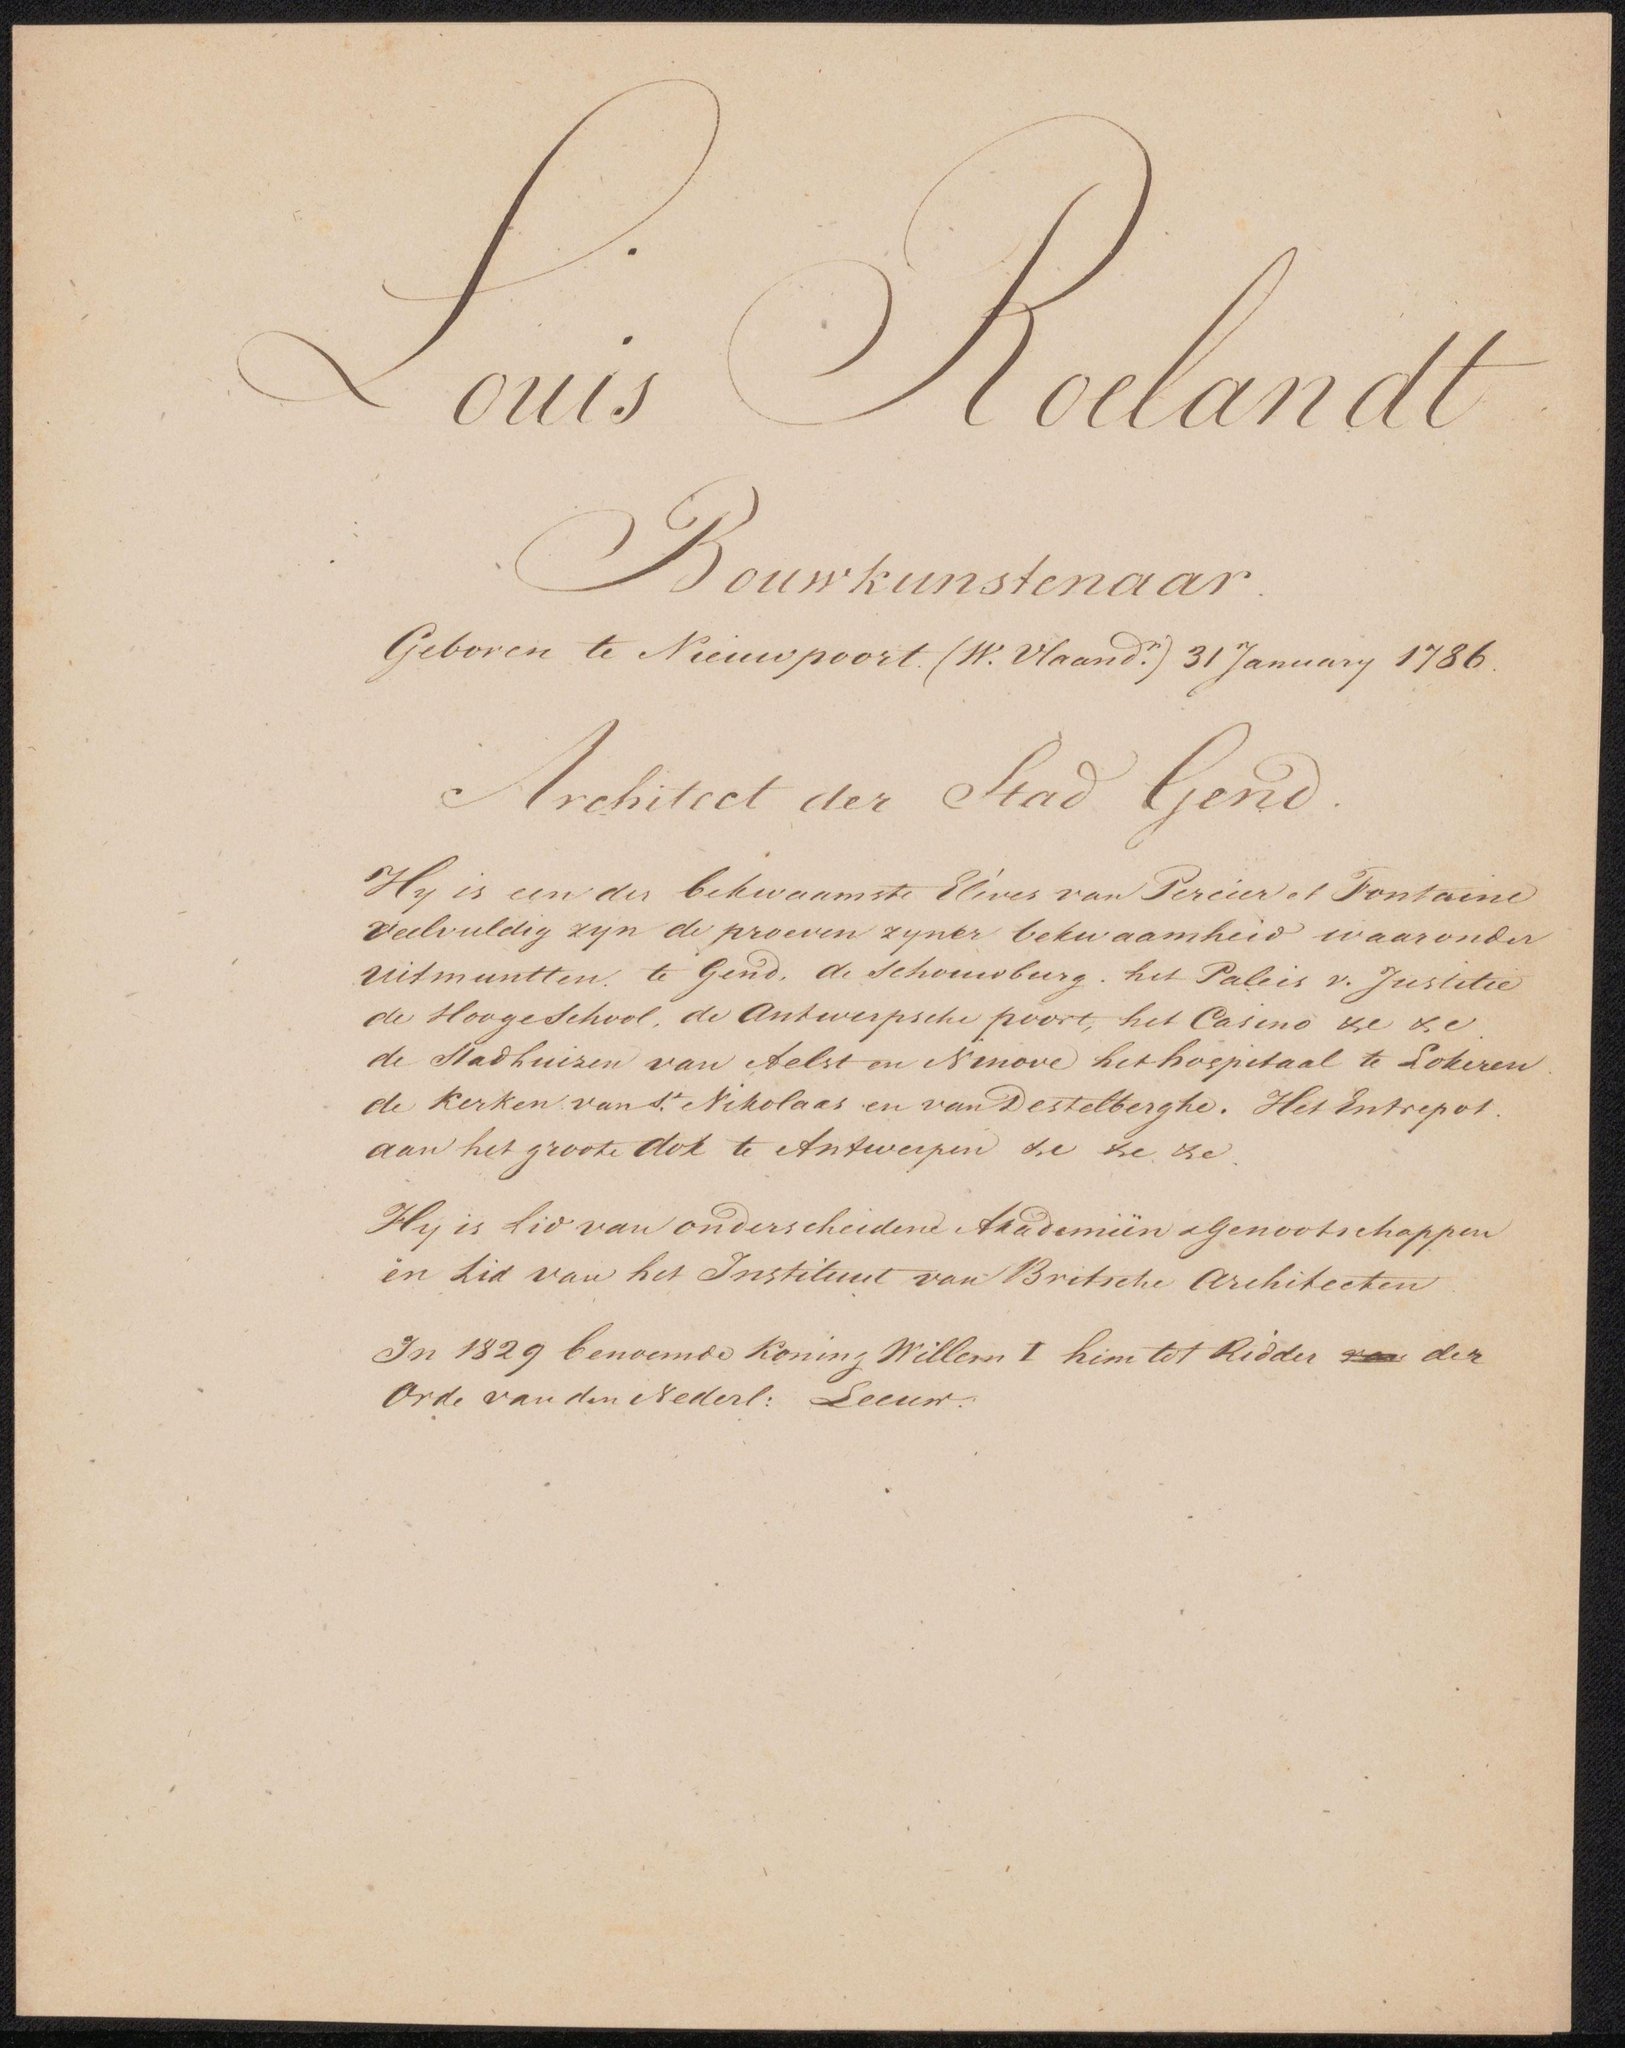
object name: manuscript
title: Handschrift betreffende Louis Roelandt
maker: Anonymous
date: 1846-1864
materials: ink, paper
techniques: pen, writing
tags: painter, louis roelandt, architecture, ghent